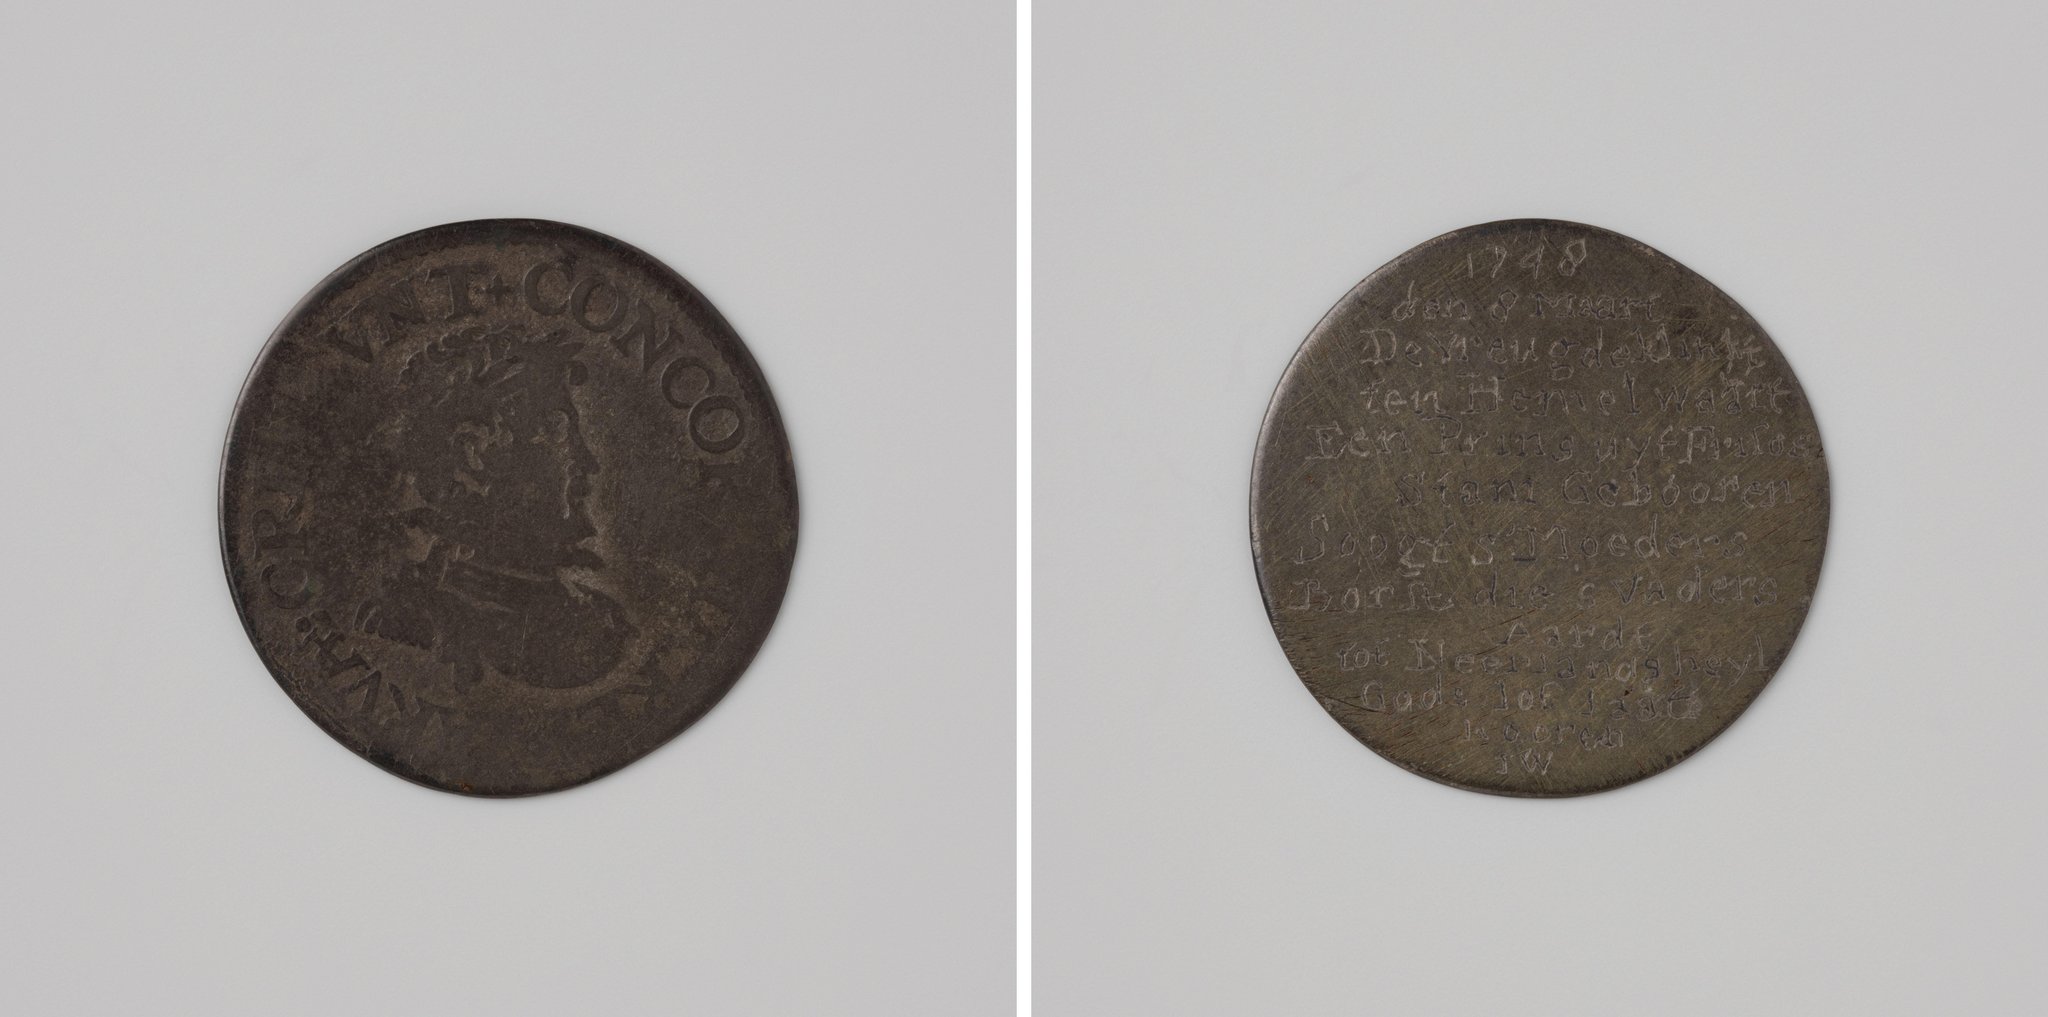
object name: history medal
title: Geboorte van prins Willem, zoon van Willem IV en Anna van Hannover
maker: Anonymous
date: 1748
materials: silver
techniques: engraving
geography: netherlands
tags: william v (prince of orange)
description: Zilveren penning. Voorzijde: borststuk man met lauwerkrans binnen omschrift. Keerzijde: opschrift